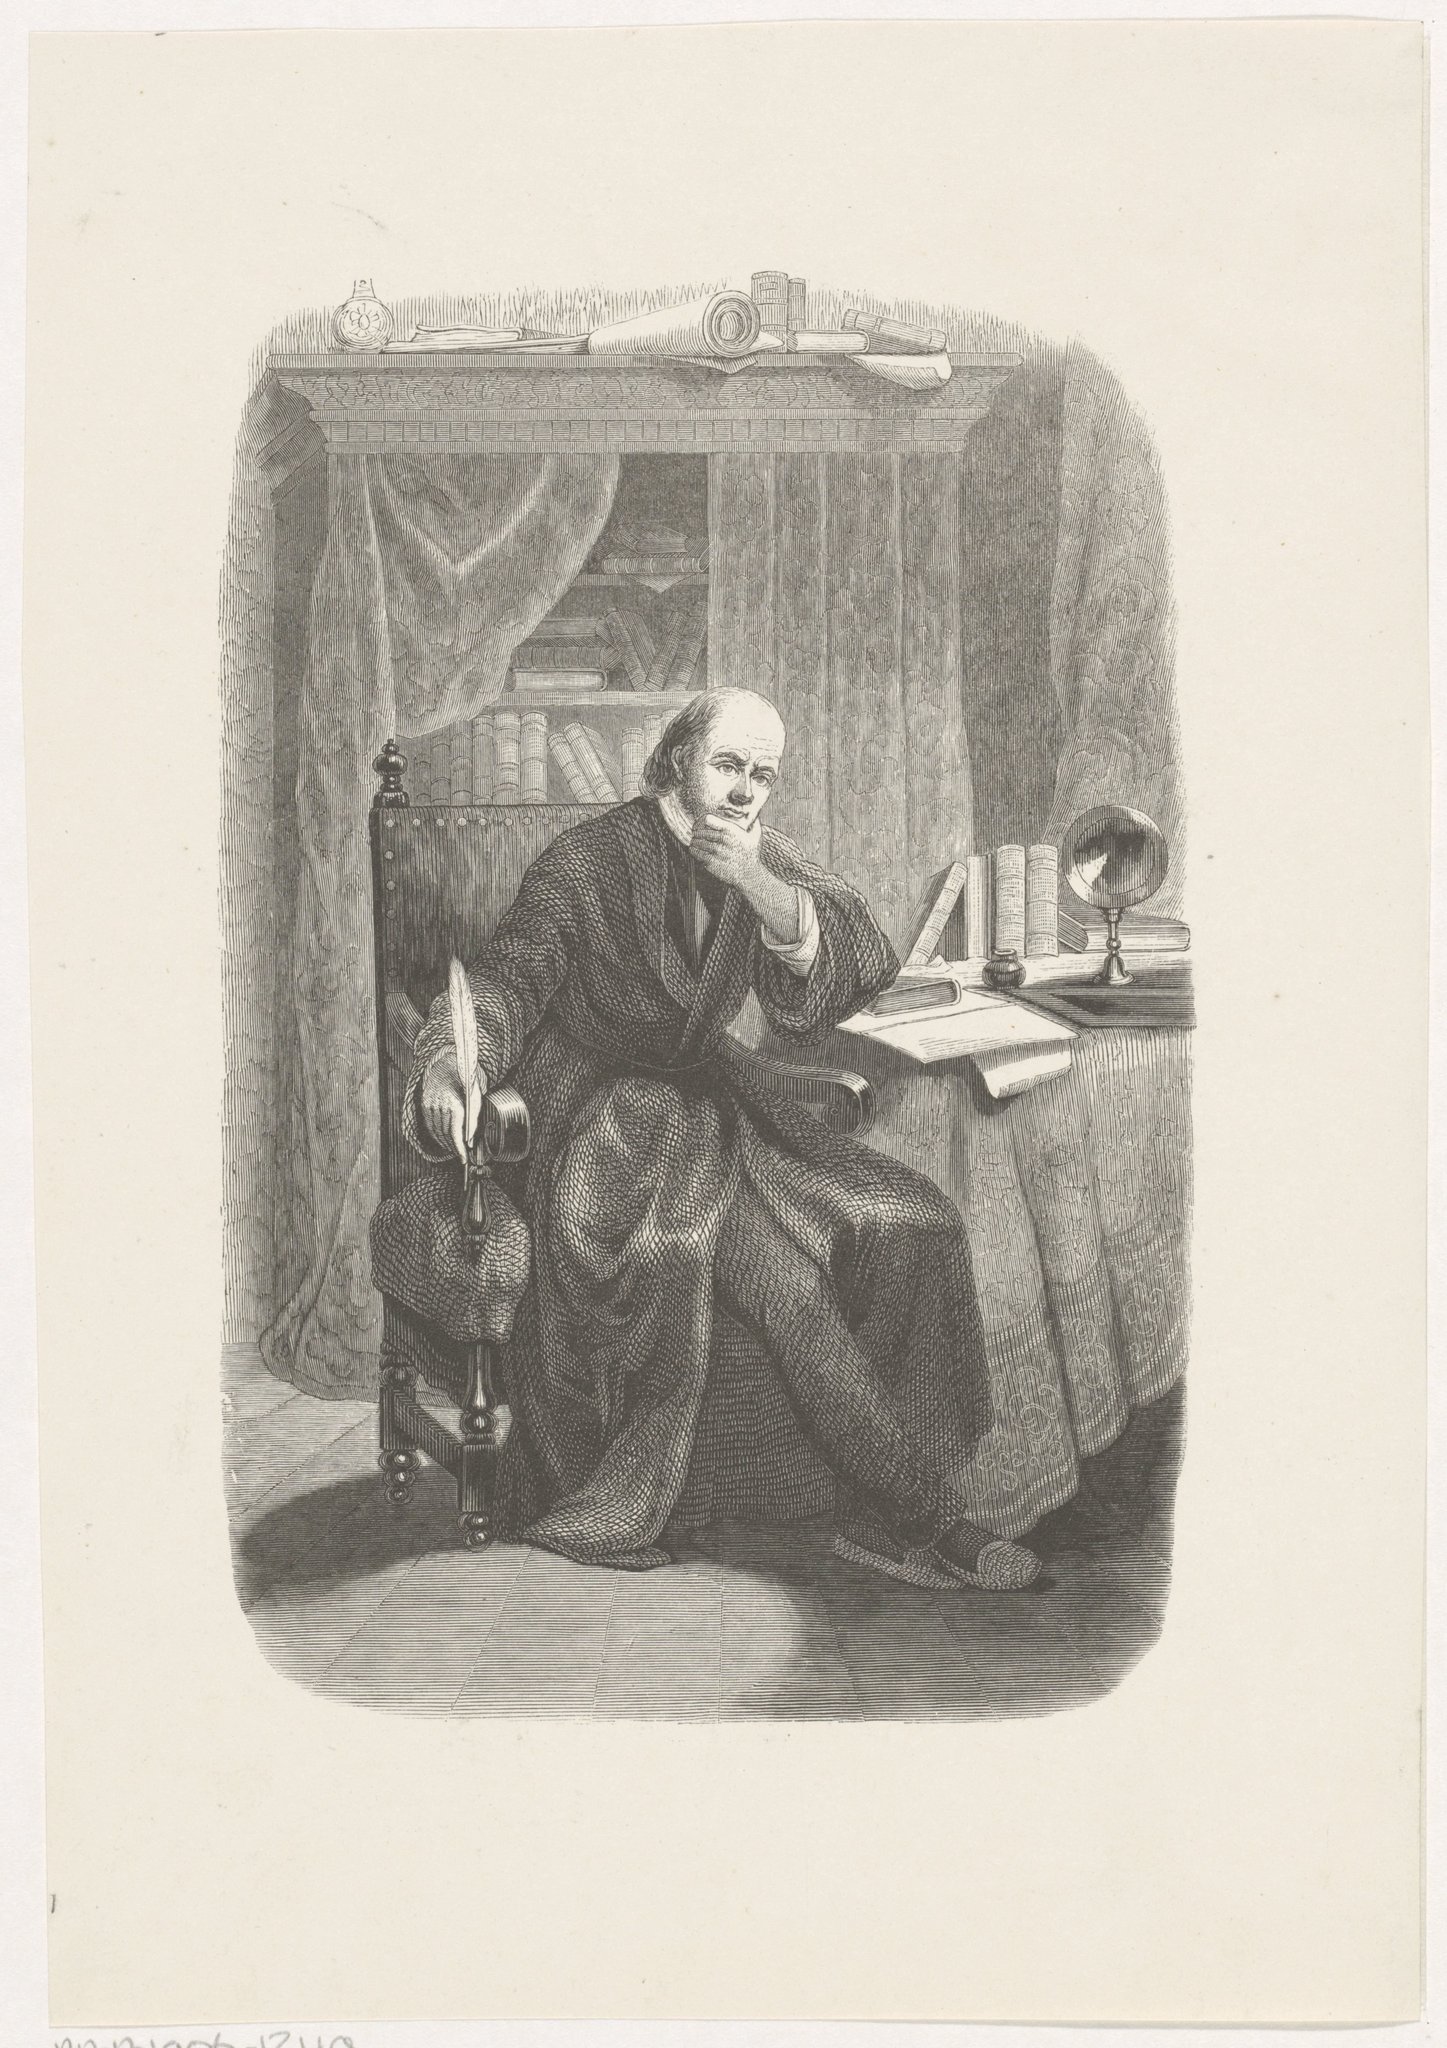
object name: print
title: Portret van Johannes Immerzeel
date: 1842-1843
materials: paper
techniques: engraving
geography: netherlands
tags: publisher, johannes immerzeel, quill, ink-well, lens, table, book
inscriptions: collector's mark: Lugt 2228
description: Prent uit: Immerzeel, Johannes. De levens en werken der Hollandsche en Vlaamsche kunstschilders, beeldhouwers, graveurs en bouwmeesters : van het begin der vijftiende eeuw tot heden. Amsterdam: J.C. van Kesteren, 1842-1843.